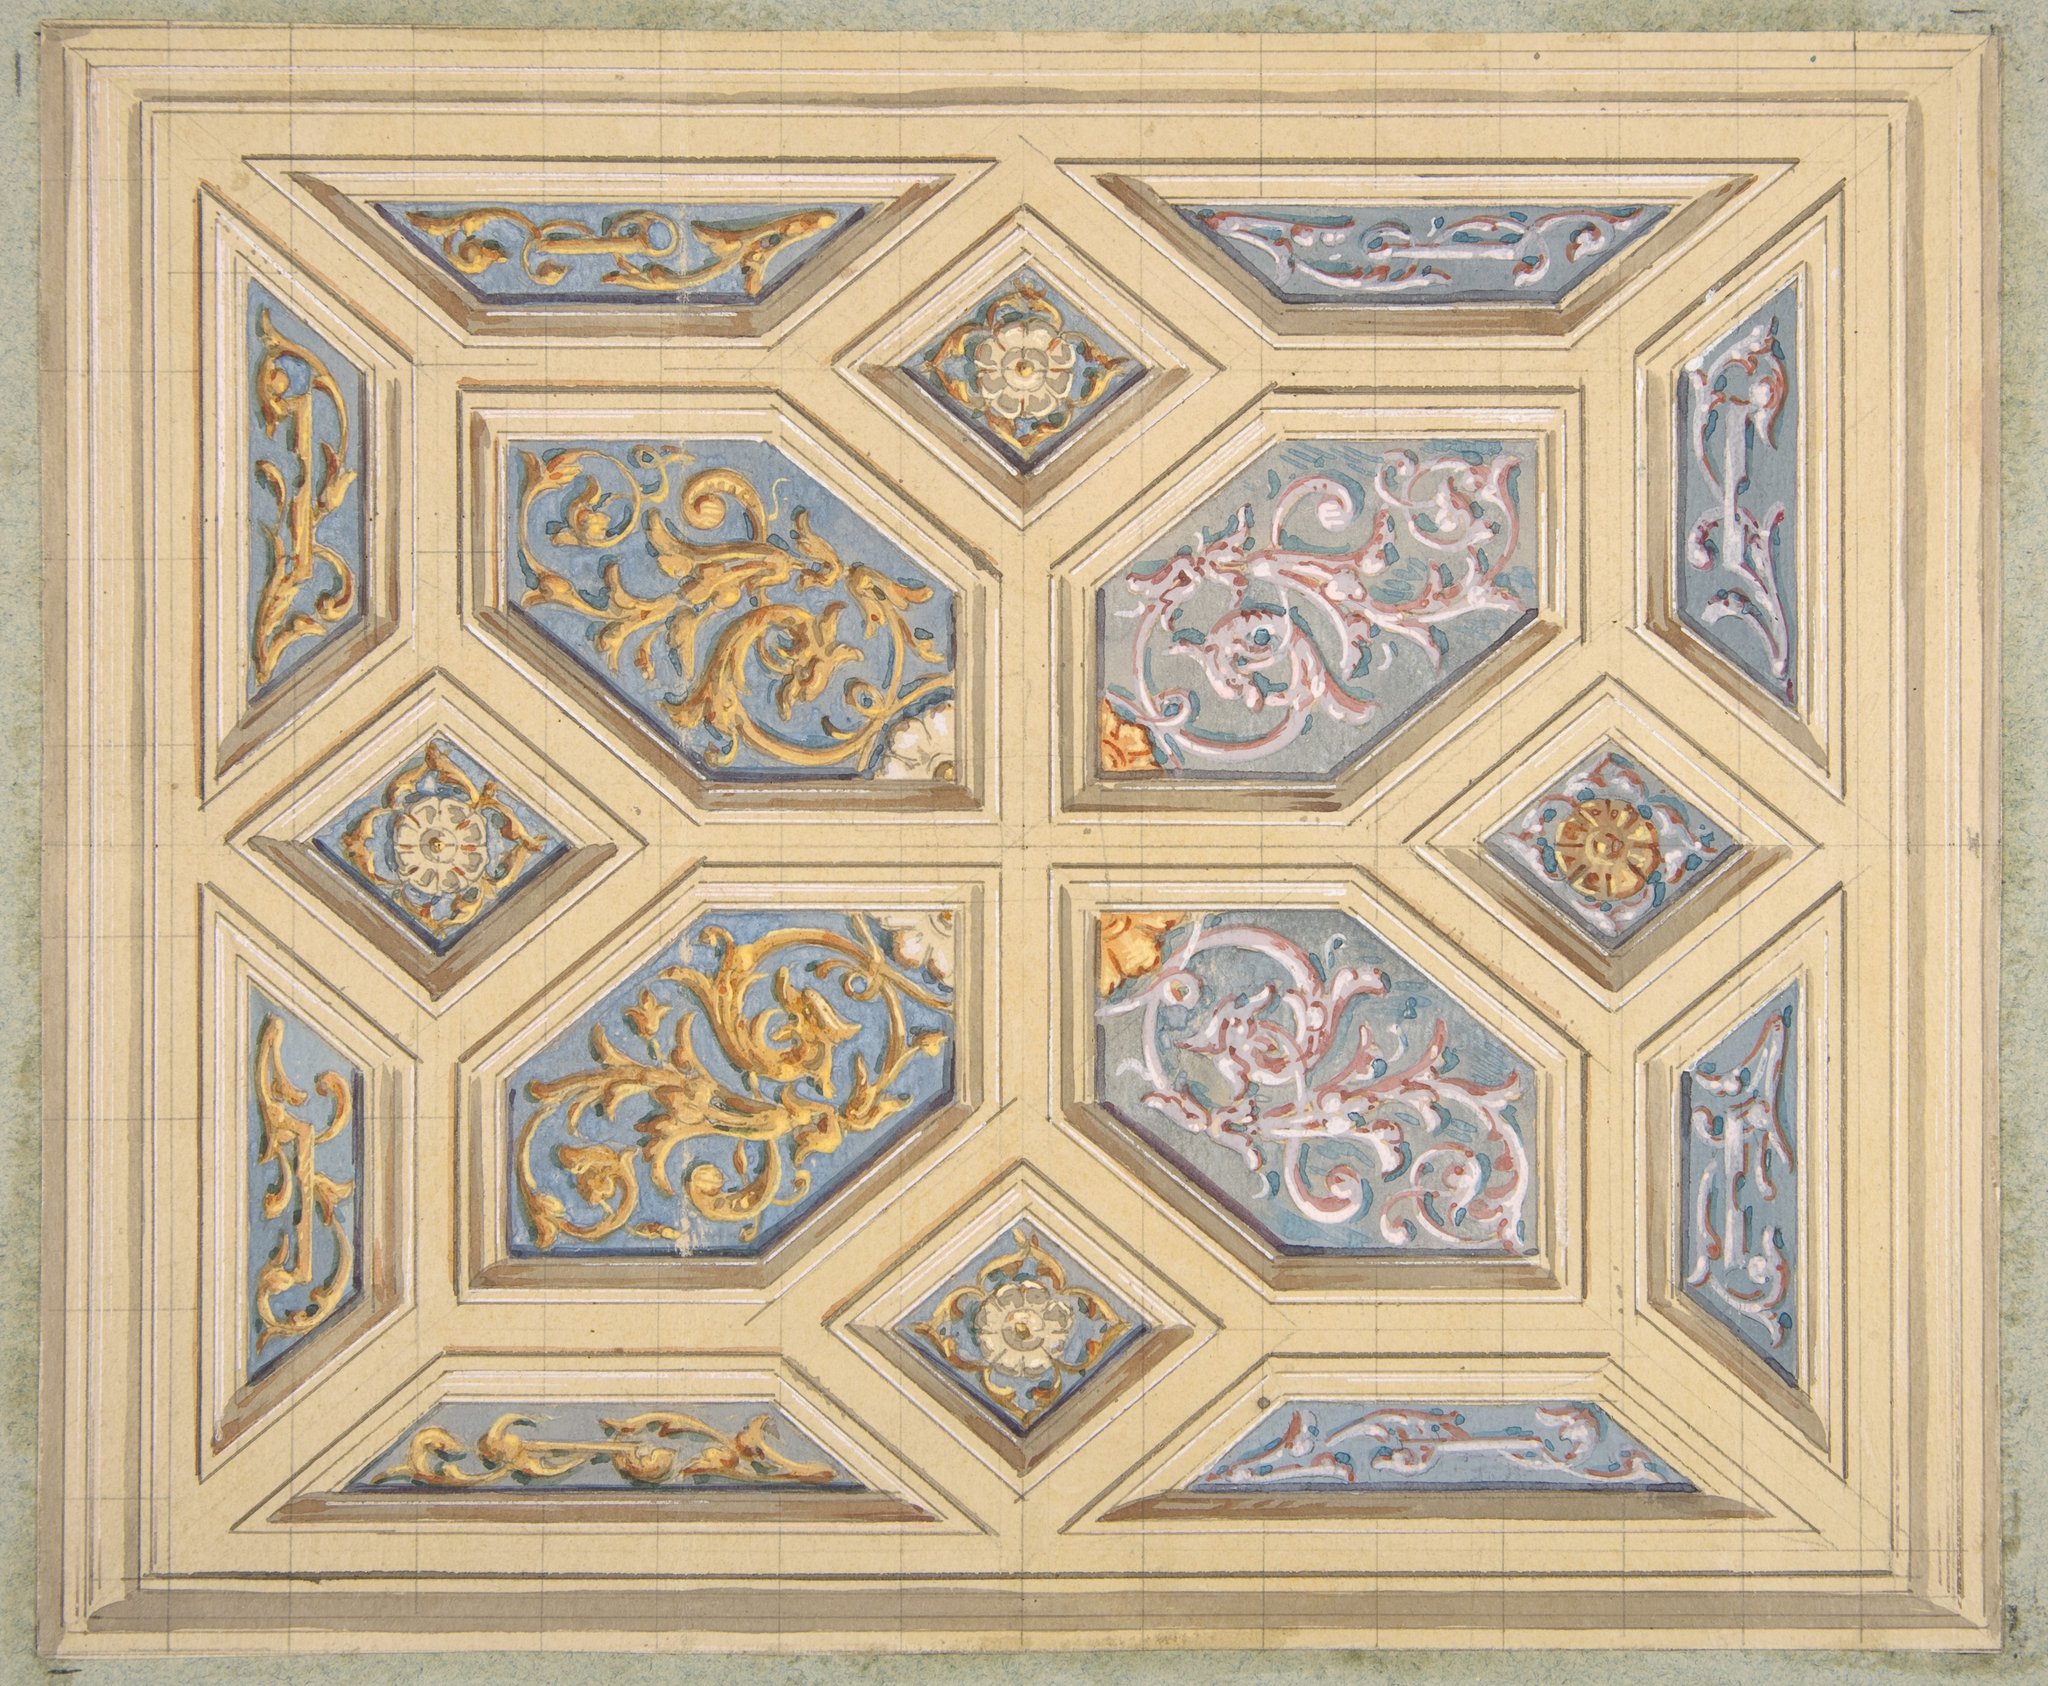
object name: drawing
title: Design for a coffered ceiling decorated with rinceaux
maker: jules-edmond-charles lachaise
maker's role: artist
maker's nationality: french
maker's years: 1897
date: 1840-1897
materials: gouache, graphite, ink, paper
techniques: inlay, pen, wash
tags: ornament